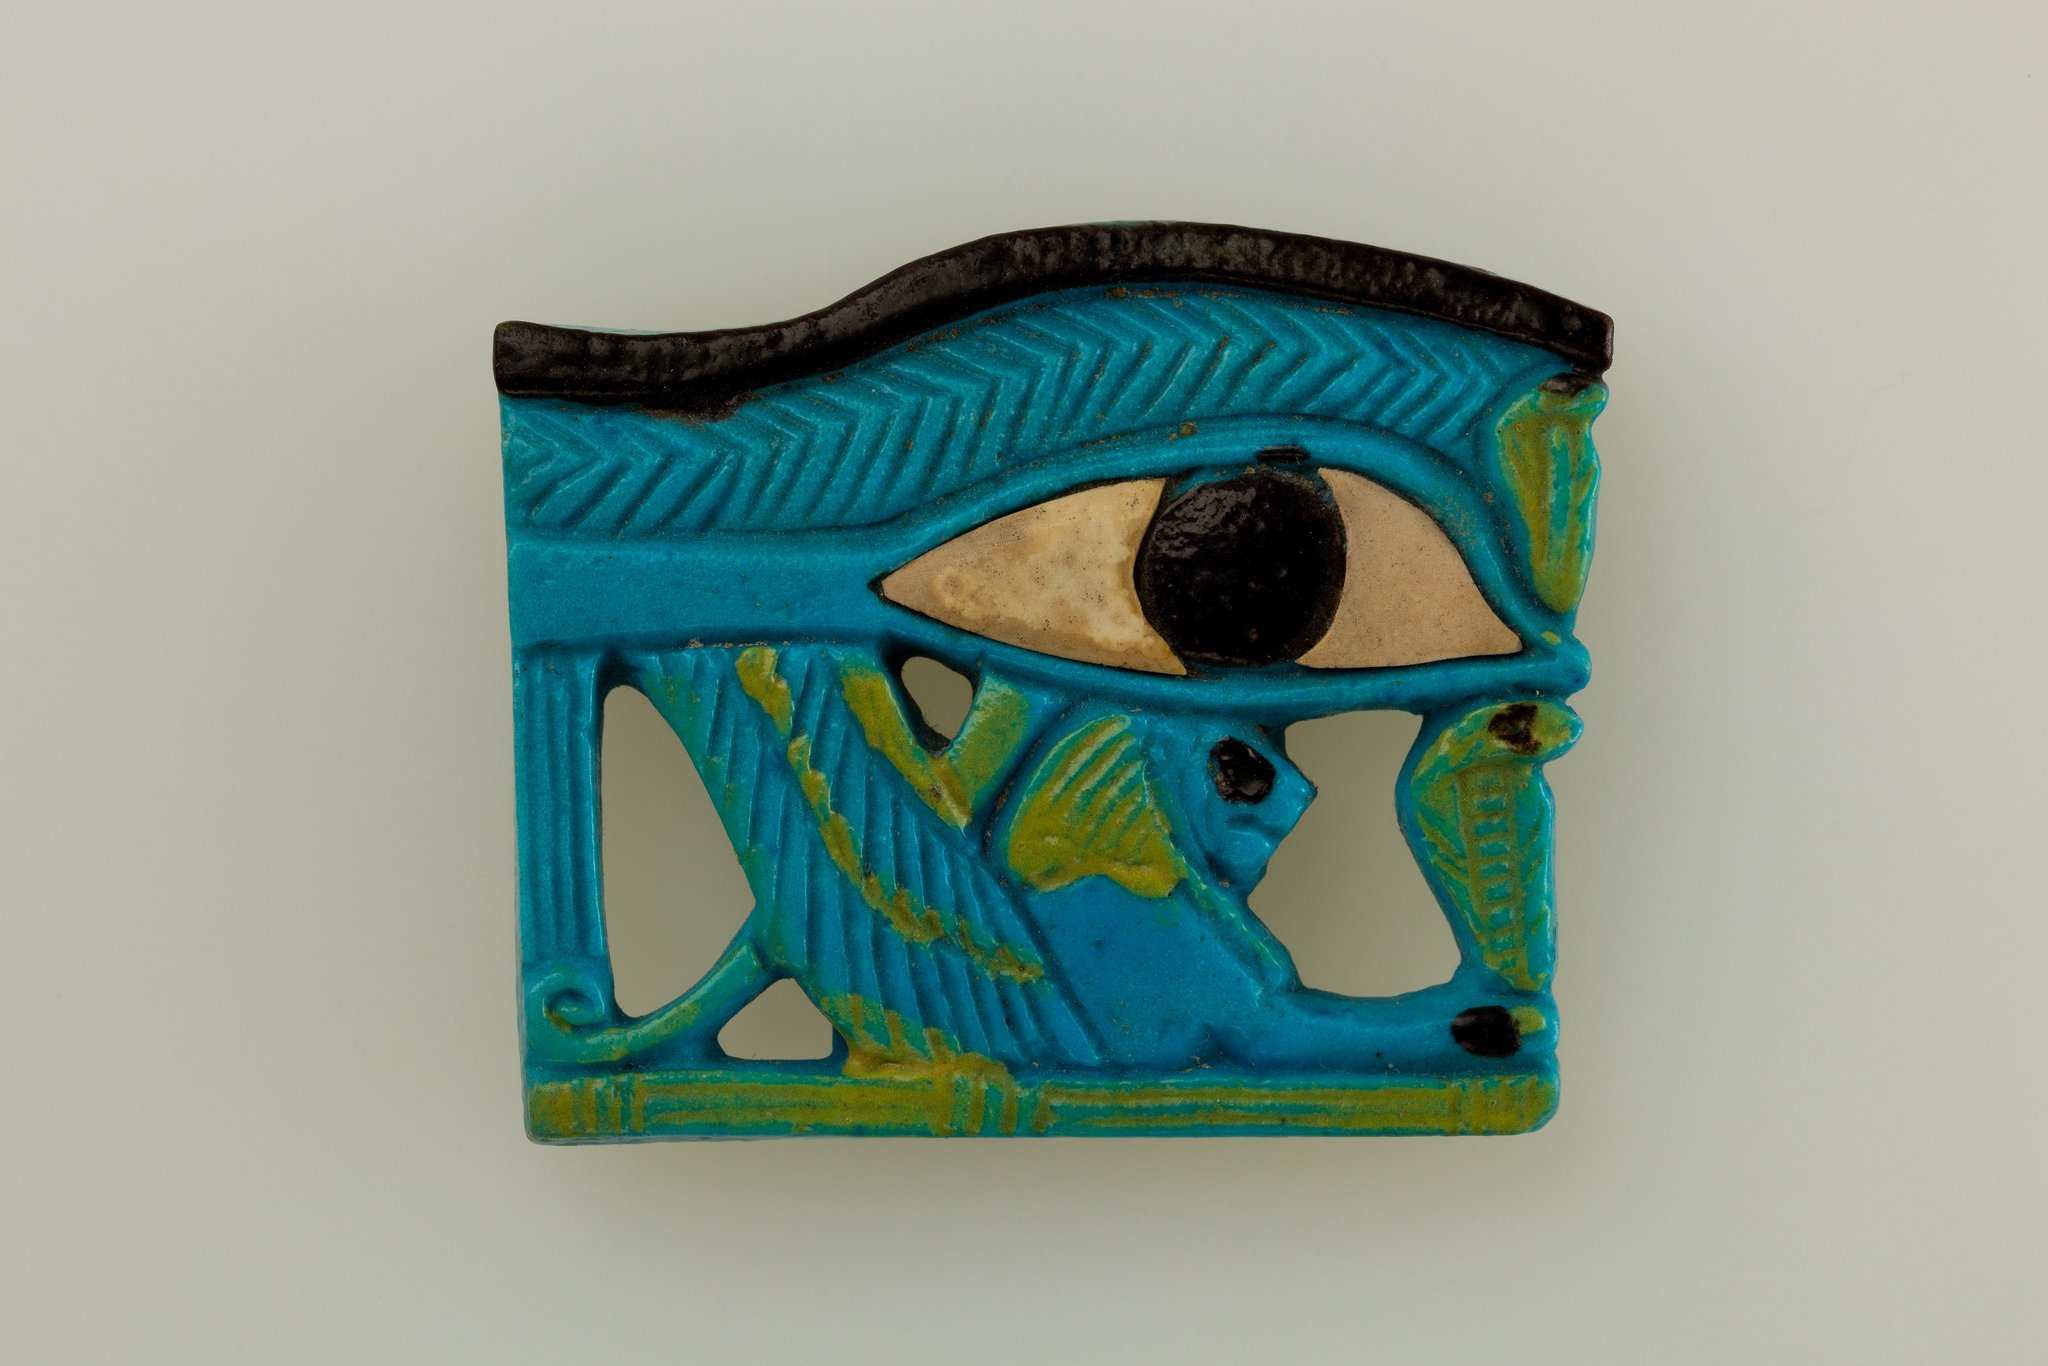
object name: amulet, wedjat eye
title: Wedjat Eye Amulet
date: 1070-664 BCE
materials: faience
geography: egypt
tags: eyes,lions,serpents